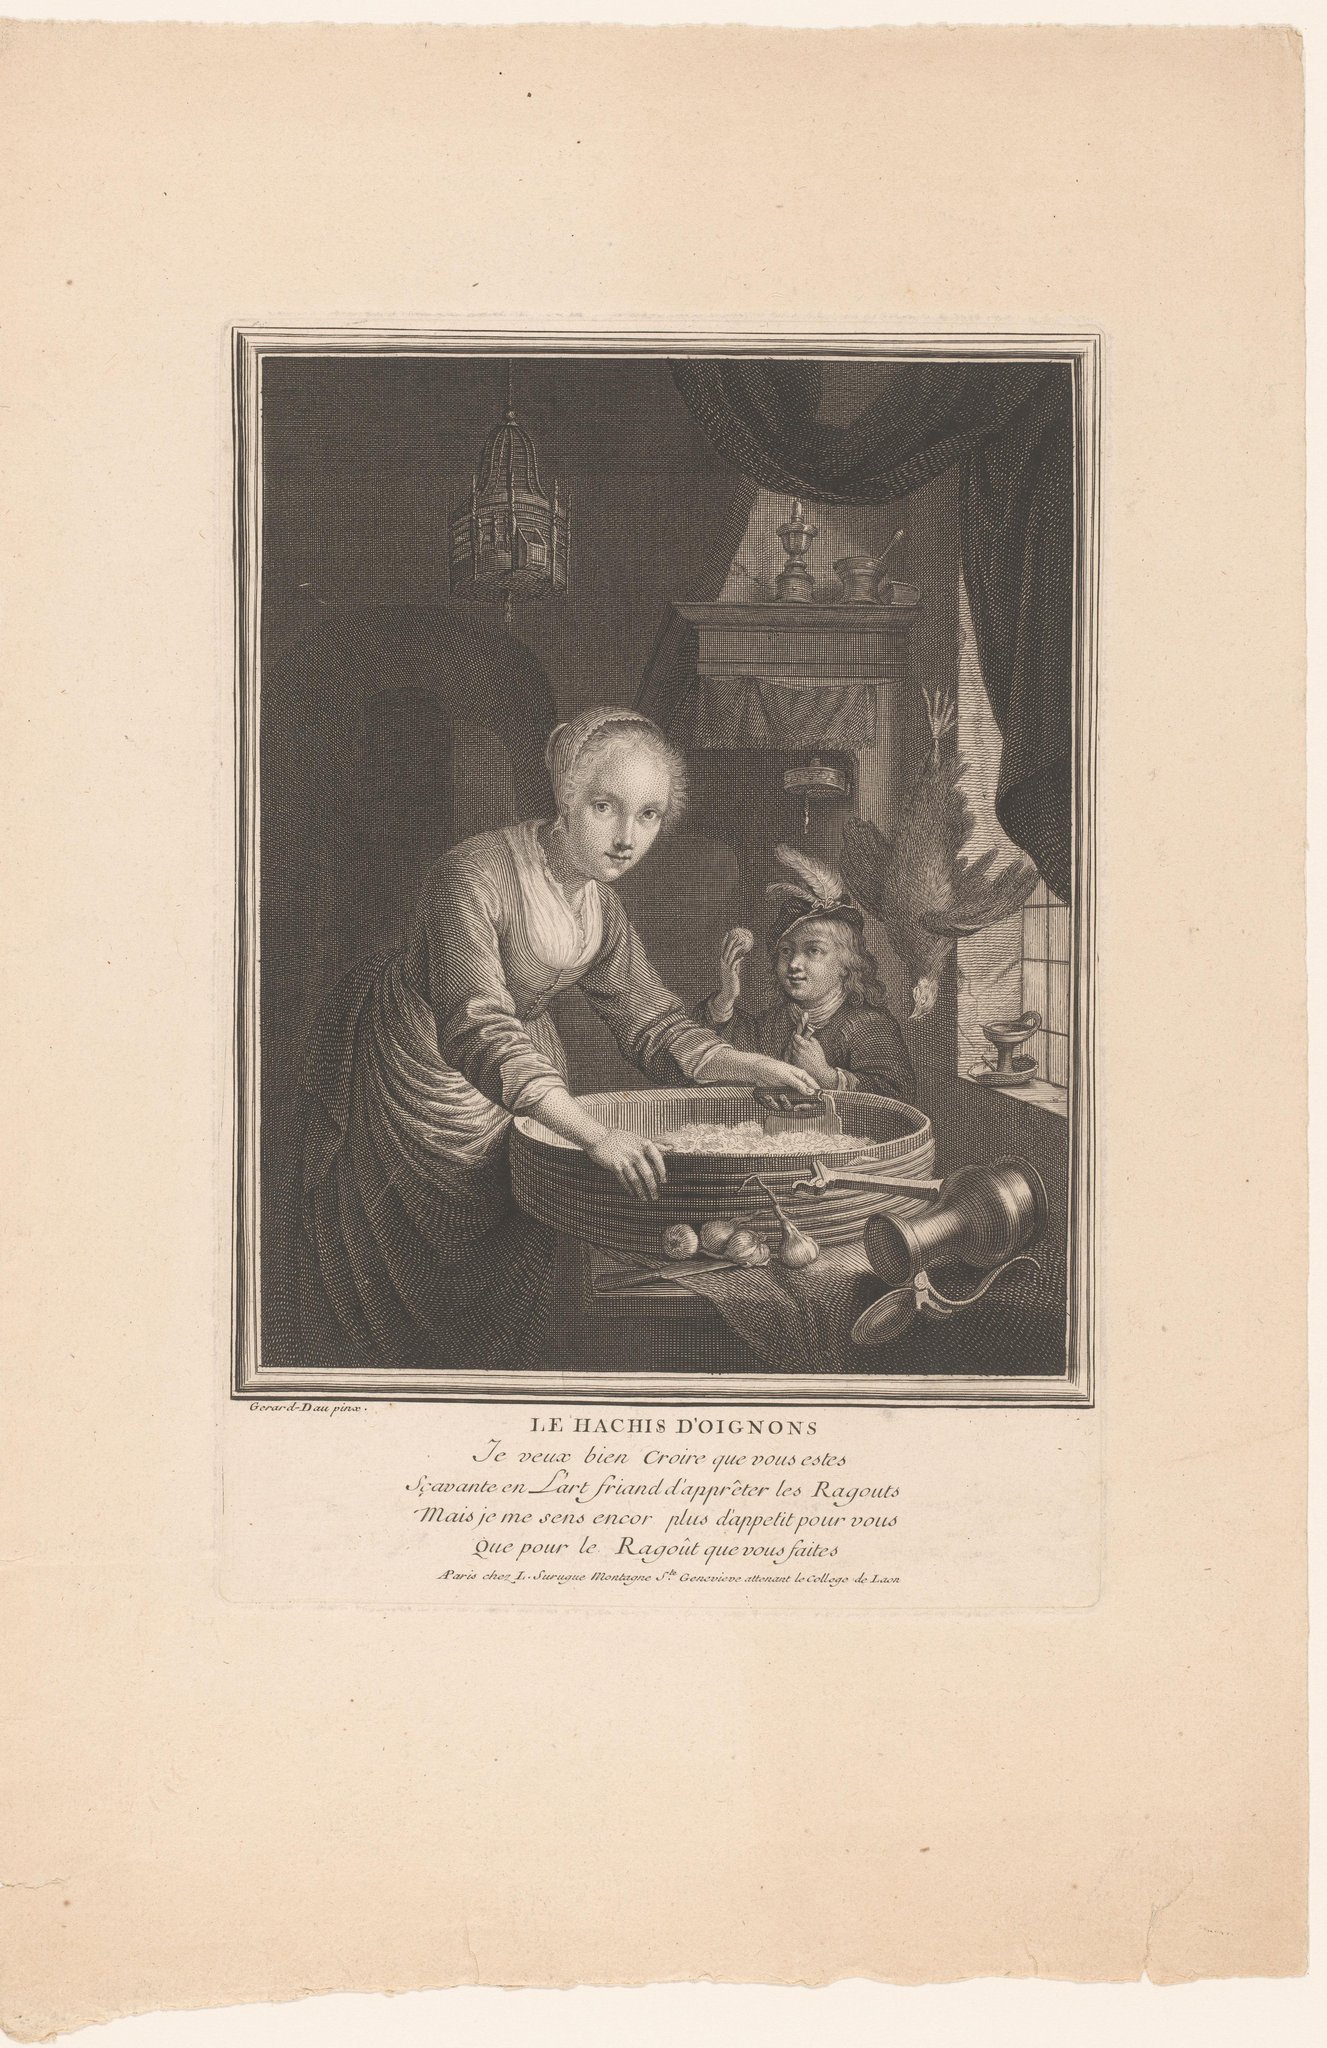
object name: print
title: Dienstmeisje hakt uien in een keuken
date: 1724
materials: paper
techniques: engraving, etching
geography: paris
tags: (non-fruit) products of plants or trees: onion, kitchen-maid, kitchen servant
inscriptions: collector's mark: Lugt 2233